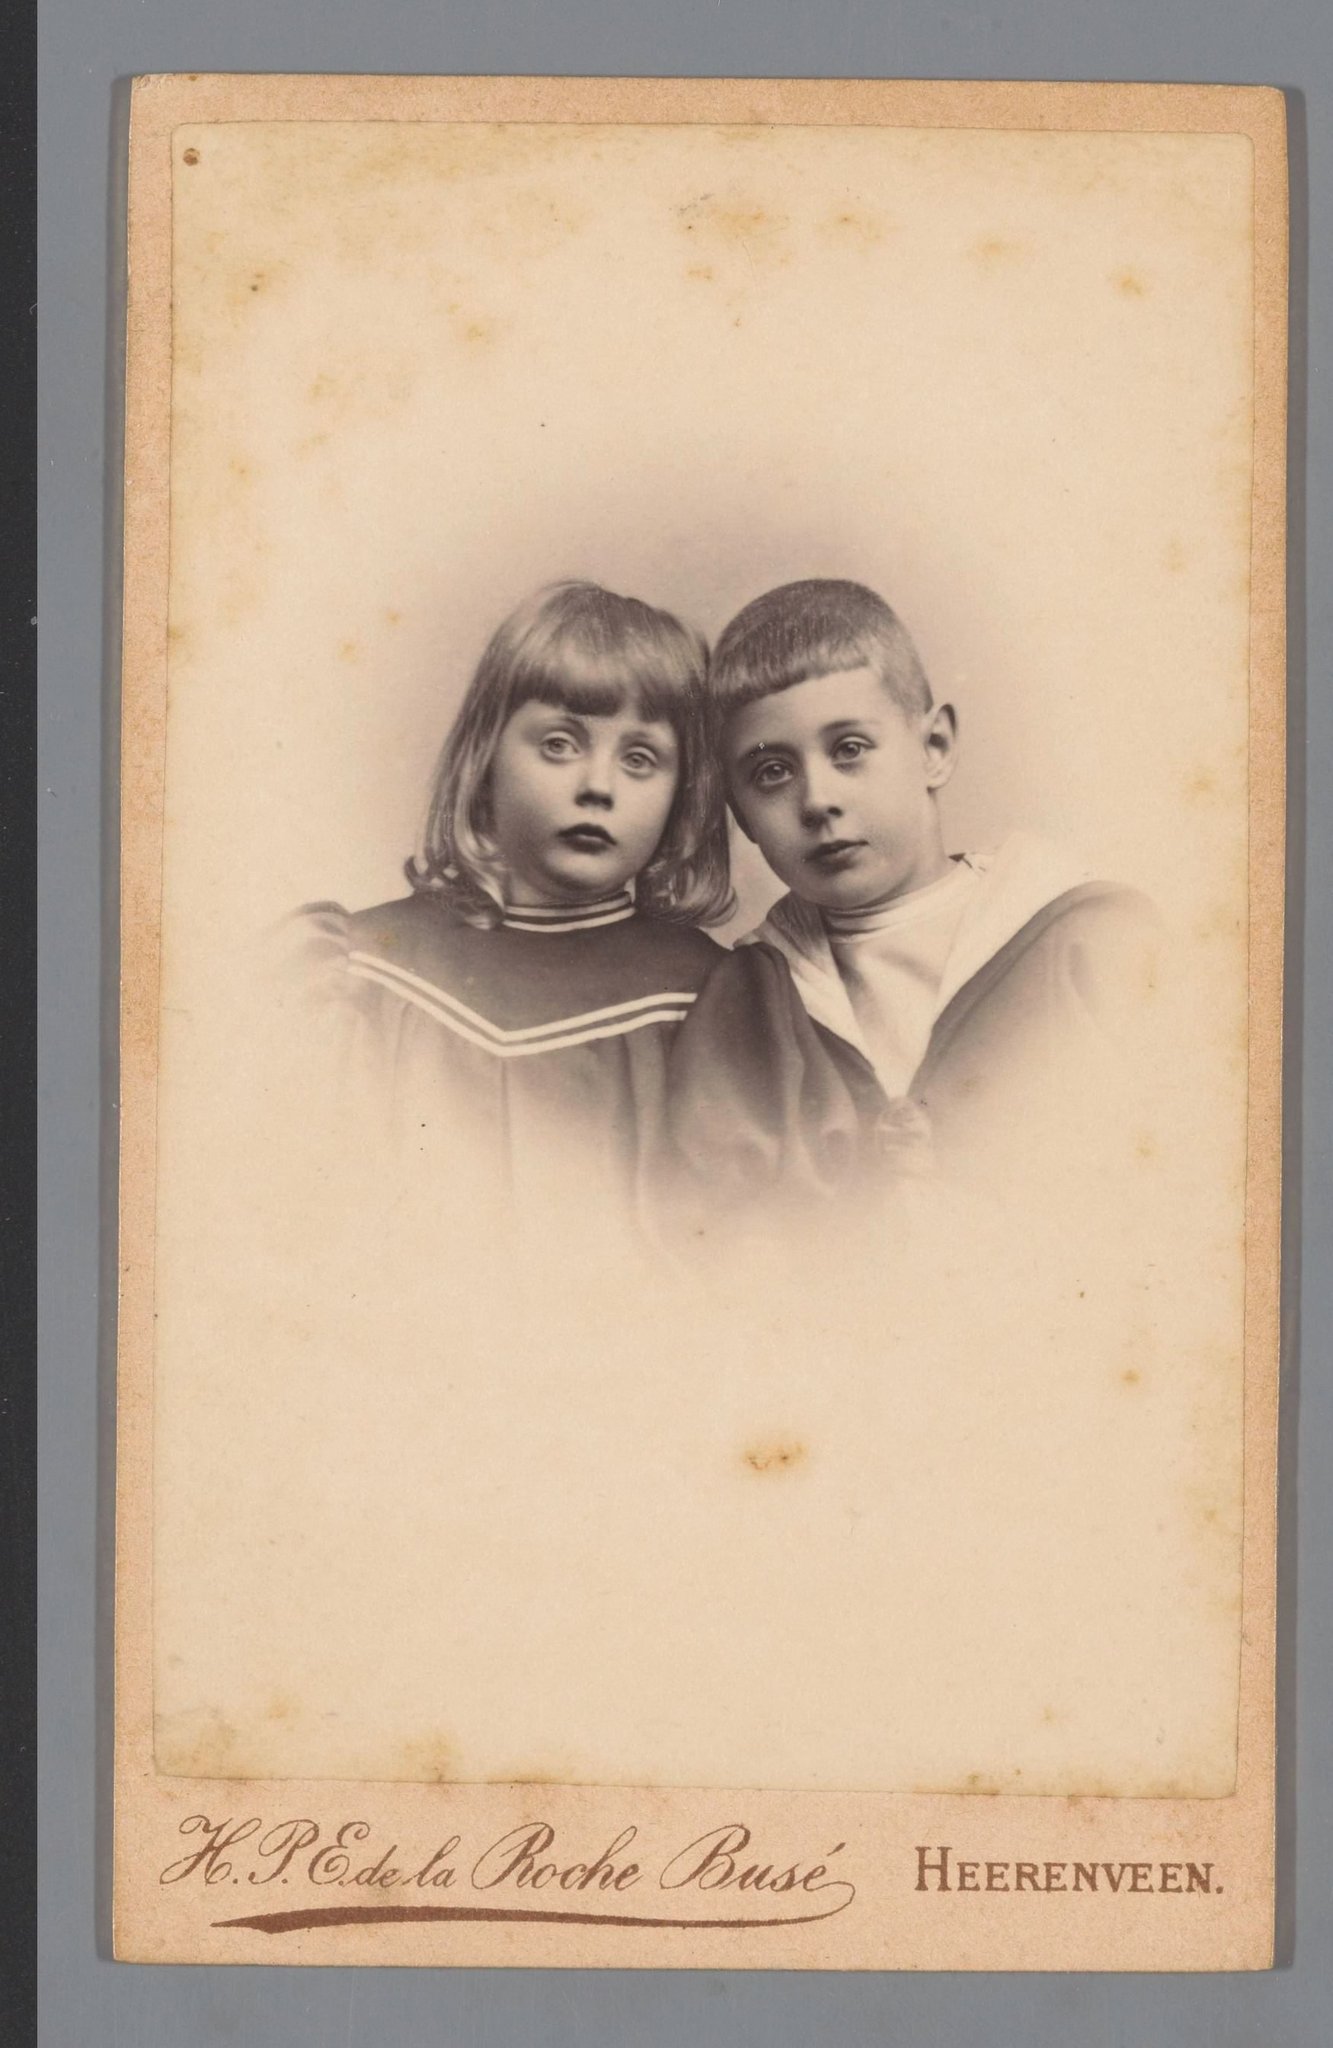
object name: carte de visite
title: Portret van twee kinderen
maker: henri paul emile de la roche busé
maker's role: fotograaf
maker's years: 1857-1940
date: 1890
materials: cardboard, paper, photographic support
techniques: albumen print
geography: heerenveen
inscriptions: address: ‘H.P.E. de la Roche Busé/Atelier voor Photographie/Heerenvaan’, annotation: ‘De platen blijven ter nabestelling bewaard./Vergrootingen naar ieder portret./Ferd. Beyrich, Berlin’, address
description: De koppen van een meisje en een jongetje met een matrozenkraag, hun hoofden naar elkaar gebogen.